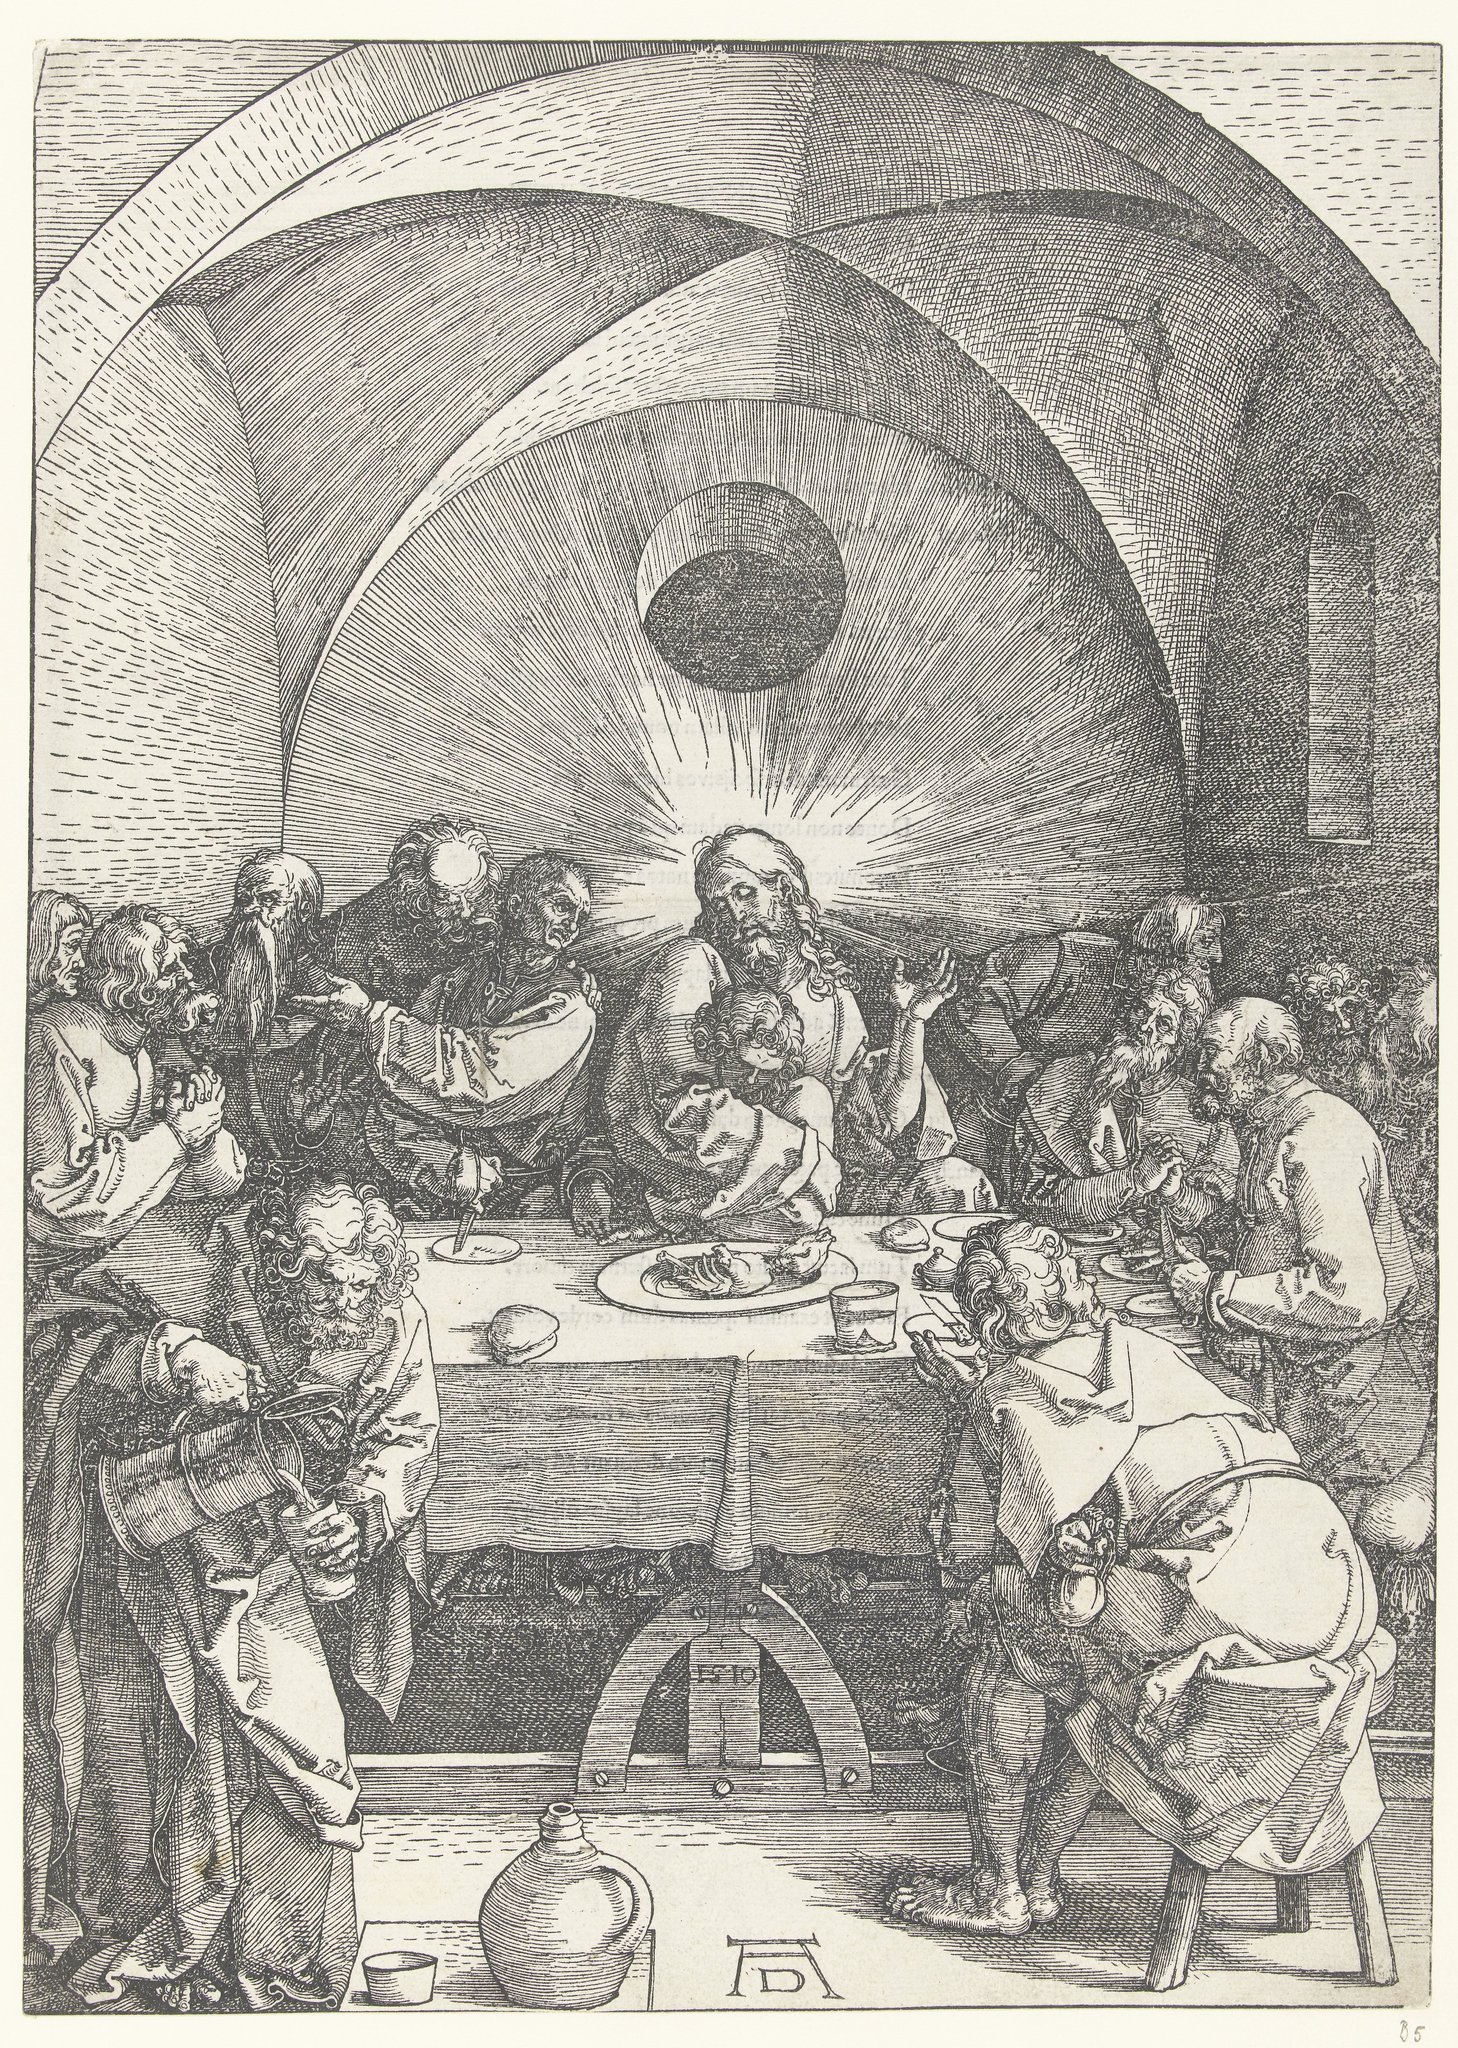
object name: print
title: De grote Passie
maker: albrecht dürer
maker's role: draughtsman, painter, print maker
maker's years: 1471-1528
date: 1510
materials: paper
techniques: letterpress printing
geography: nuremberg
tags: last supper (in general) (matthew 26:21-35; mark 14:18-31; luke 22:3, 22:15-23; john 13:21-38)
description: Johannes vleit zich aan de borst van Christus tijdens het Laatste Avondmaal. Op versozijde gedrukte Latijnse tekst. Deze prent is onderdeel van de prentserie 'De grote Passie', bestaande uit een titelprent en 11 scènes uit het Lijdensverhaal.